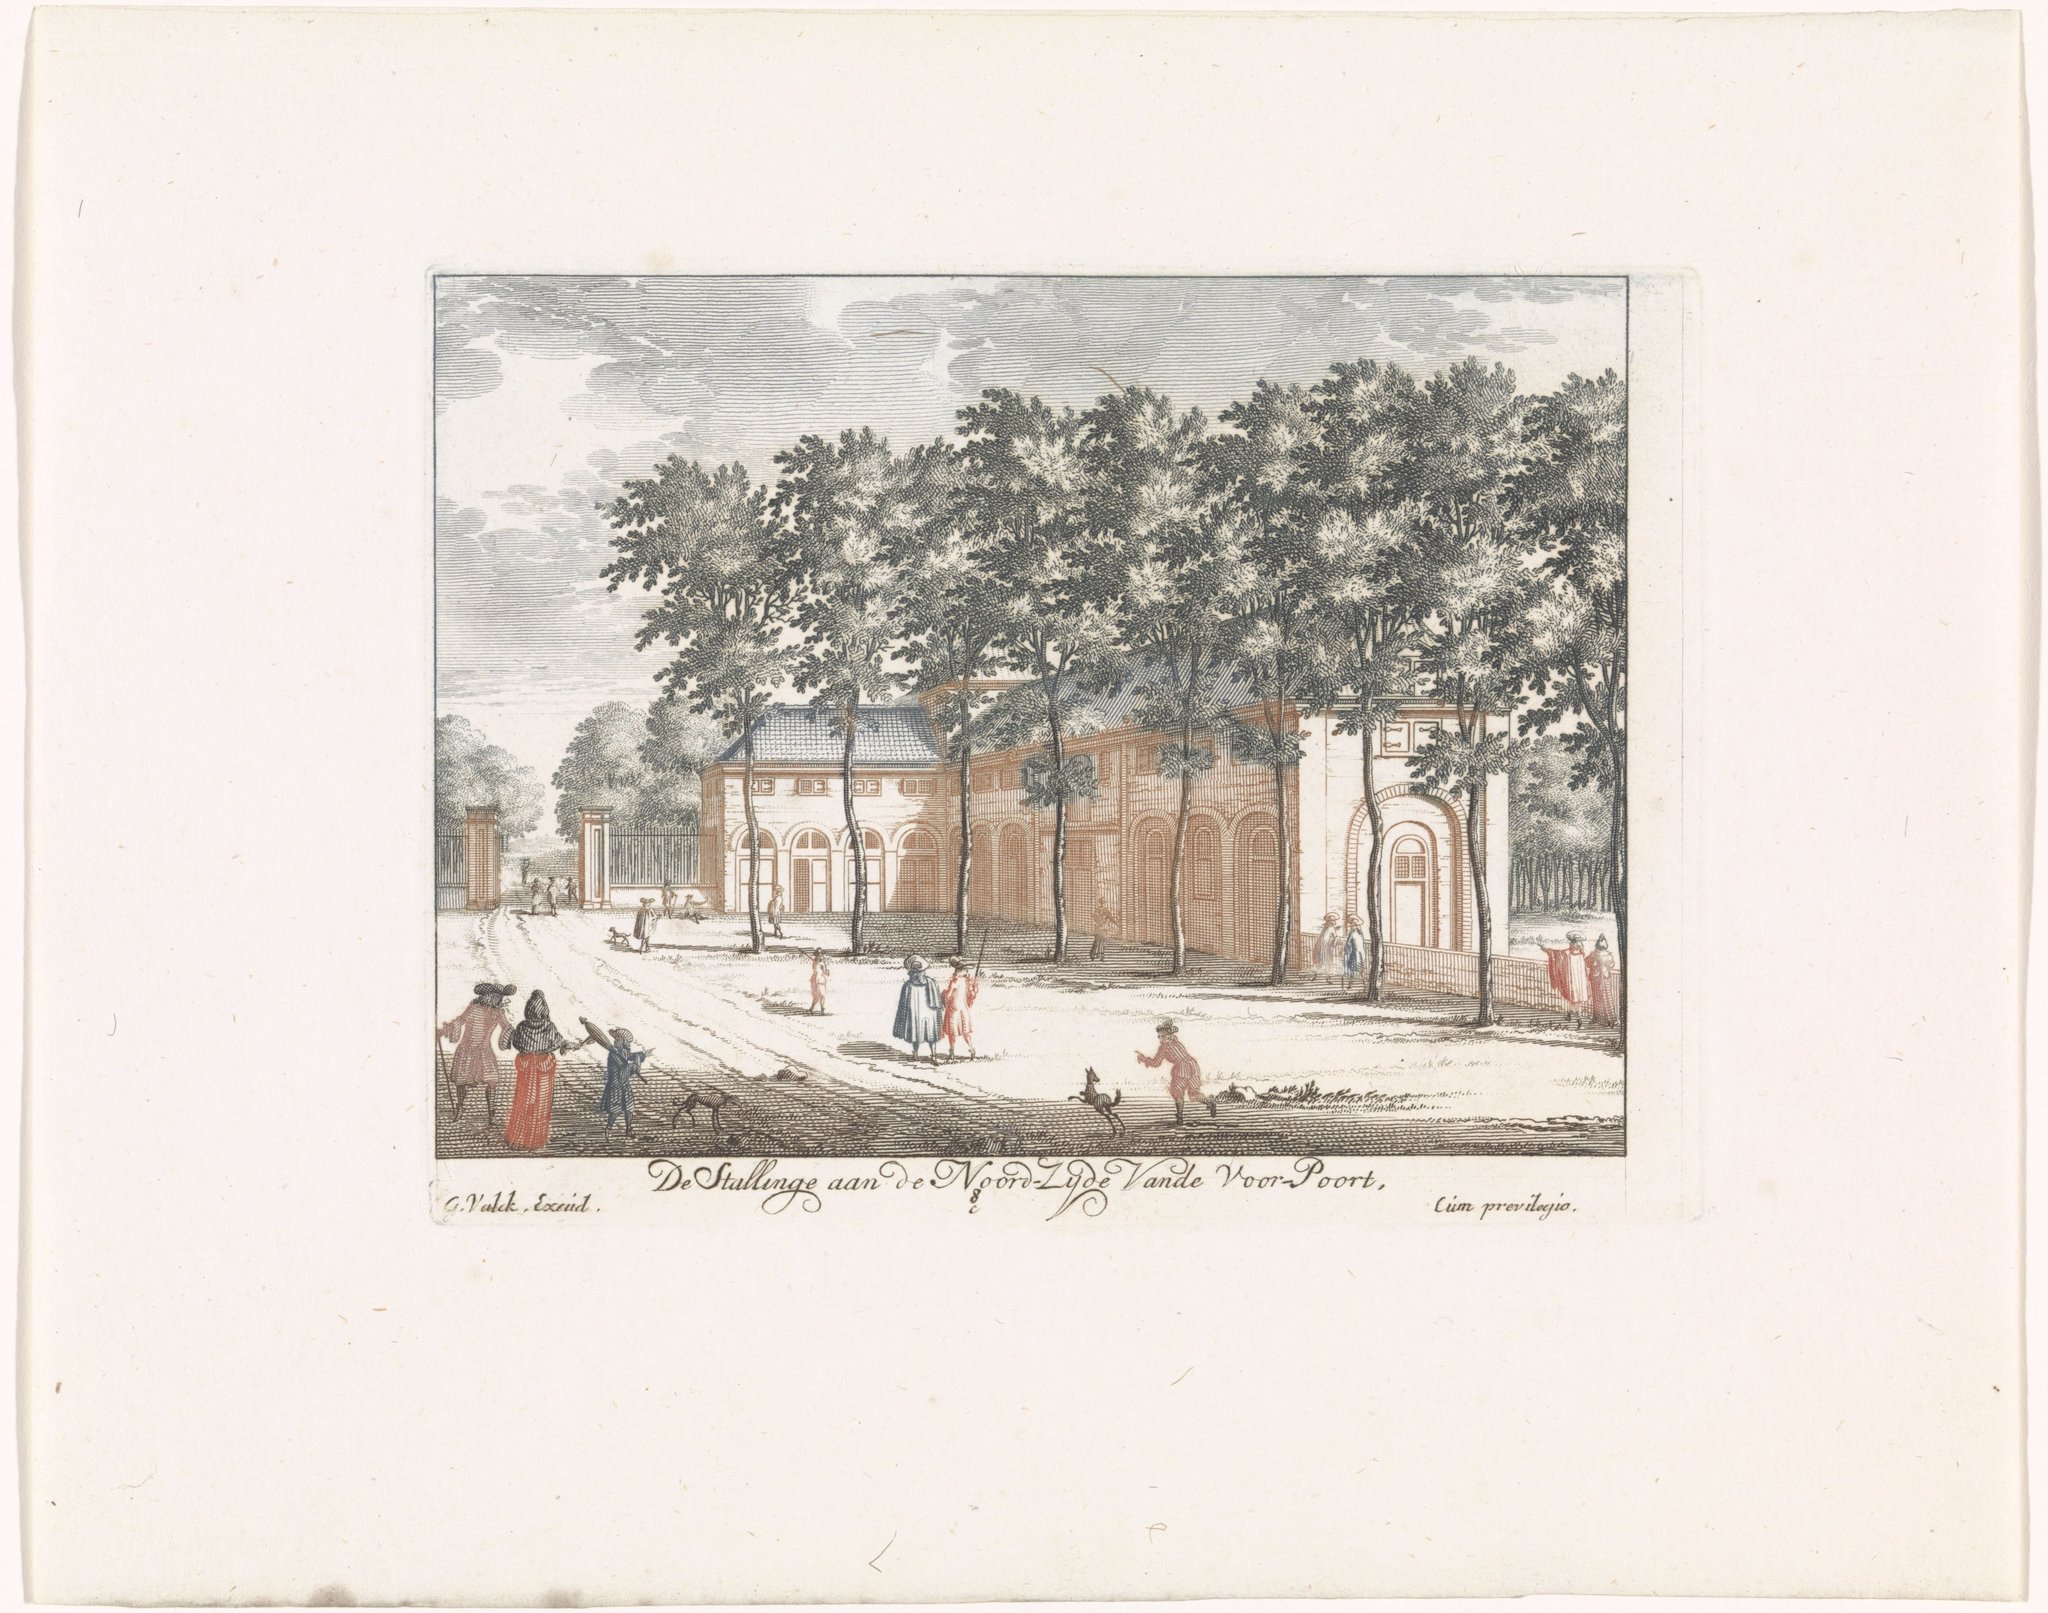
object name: print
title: Gezicht op de stallen aan de noordzijde van de voorpoort bij Paleis Soestdijk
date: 1695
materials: paper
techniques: etching, lithography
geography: amsterdam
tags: the hague, william iii (prince of orange and king of england, scotland, and ireland), gate, entrance, stall, stable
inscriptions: collector's mark: Lugt 2760, collector's mark: Lugt 2228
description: De stallen van Paleis Soestdijk, jachtslot van stadhouder Willem III van Oranje-Nassau, aan de noordzijde van de poort. Op de voorgrond wandelaars met honden op de weg.